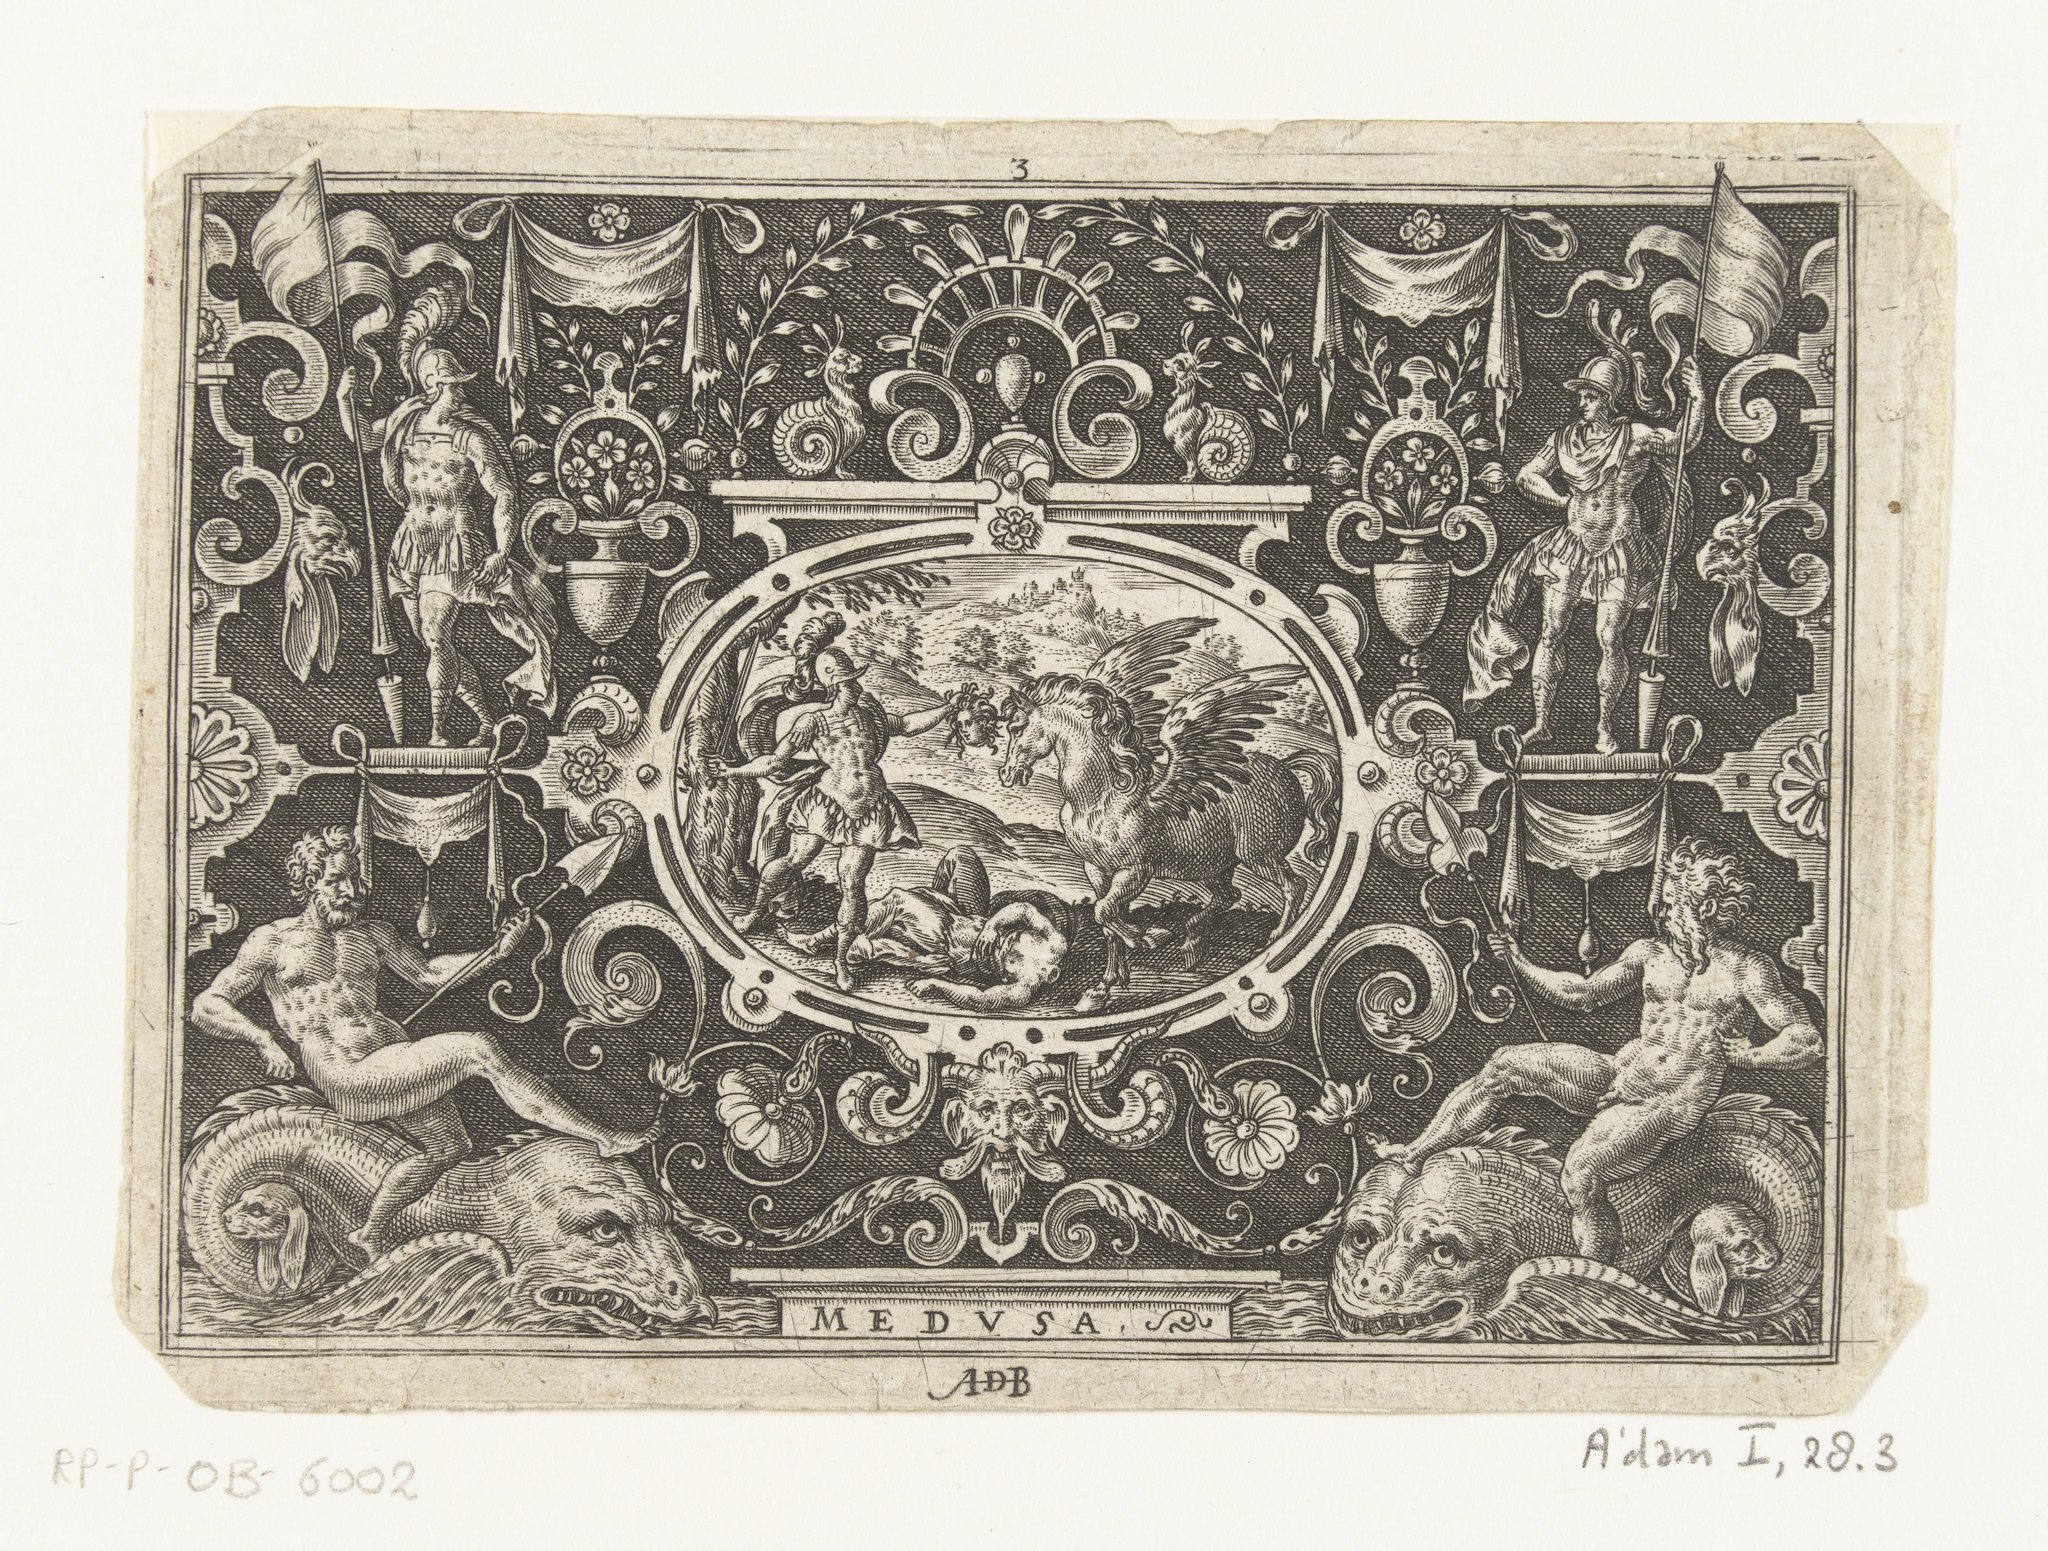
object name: print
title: Ovale cartouches met voorstellingen uit het leven van Perseus in omlijsting van grotesken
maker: abraham de bruyn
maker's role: print maker, publisher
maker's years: 1540-1587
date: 1584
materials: paper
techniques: engraving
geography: netherlands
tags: ornament ~ grotesque, fabulous animals ~ fishes, vase ~ ornament, ornament ~ cartouche, perseus beheading medusa, with pegasus, and possibly also chrysaor, the warrior with the golden sword, springing from the blood of medusa's head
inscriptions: title: ‘MEDUSA’, monogram: ‘ADB’, number: ‘3’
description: Perseus met het hoofd van Medusa. Haar lijk aan zijn voeten. In de omlijsting linksonder en rechtsonder een man op een zeemonster. Daarboven een krijgsman met vaandel. Gearceerde achtergrond.